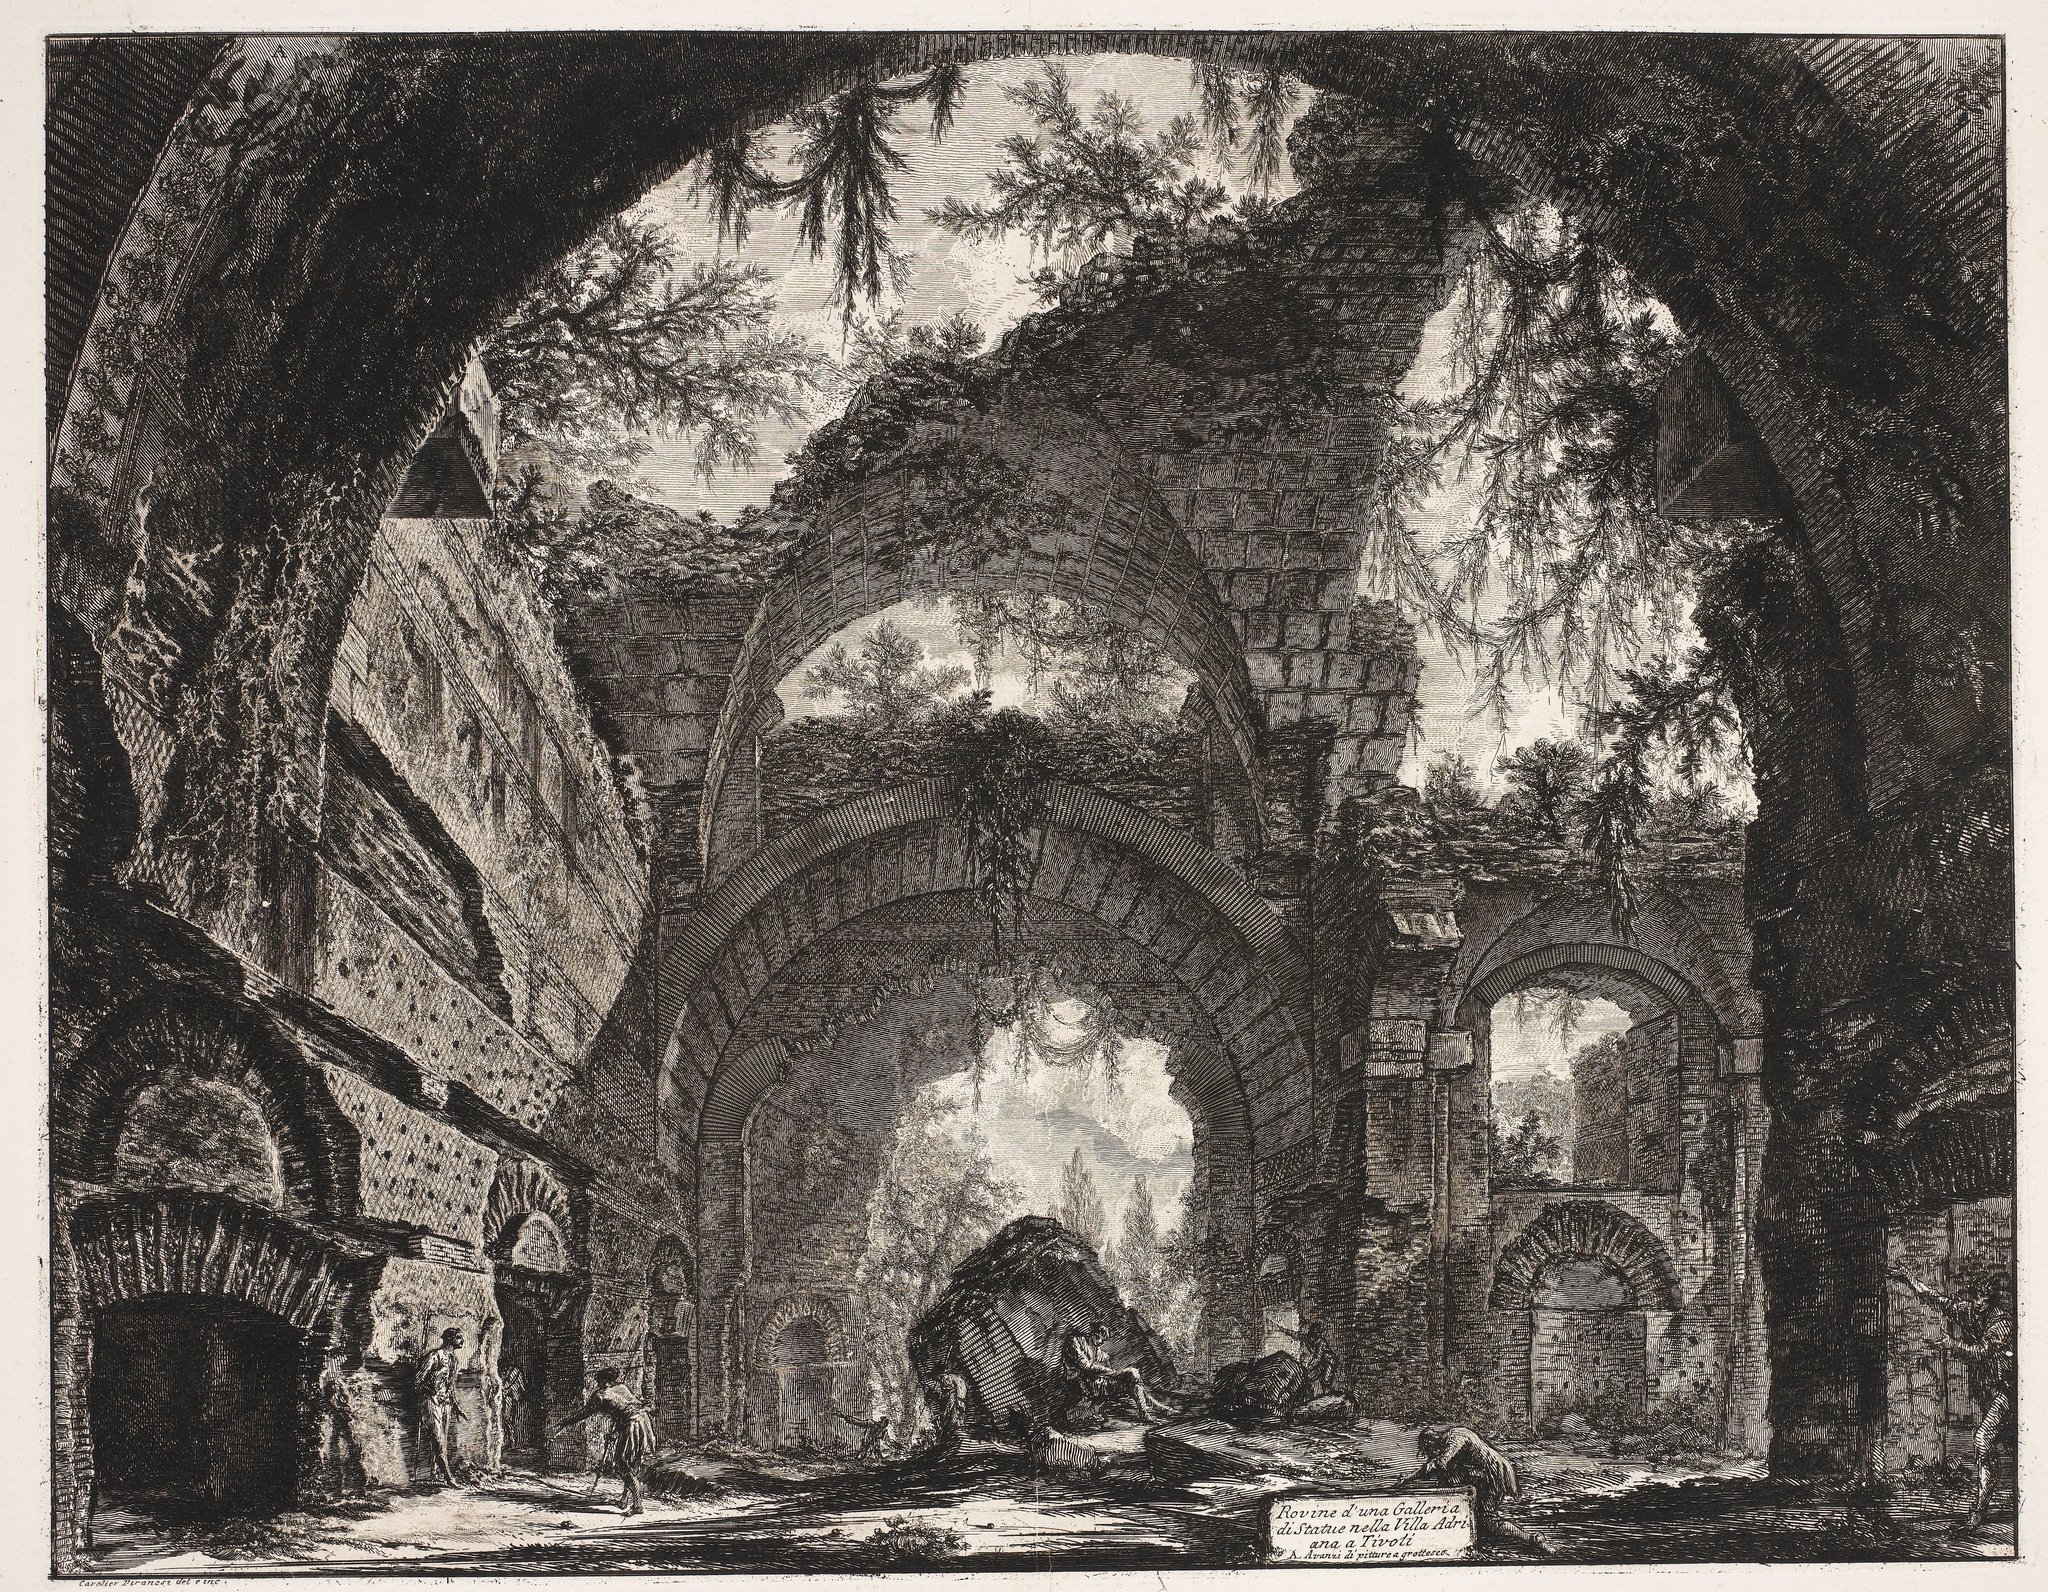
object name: print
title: Vedute di Roma disegnate ed incise da Giambattista Piranesi architetto Ve(nez)iano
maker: giovanni battista piranesi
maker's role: designer, draughtsman, print maker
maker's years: 1720-1778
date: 1748-1778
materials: paper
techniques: etching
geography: rome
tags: ruin of a building ~ architecture, landscape with ruins, public baths, villa, tivoli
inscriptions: collector's mark: Lugt 2228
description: Deze prent maakt deel uit van de serie 'Vedute di Roma'. Piranesi werkte aan deze 135 platen tellende serie tussen 1748 en zijn dood in 1778. Francesco Piranesi voegde later nog twee prenten toe aan de reeks van zijn vader.